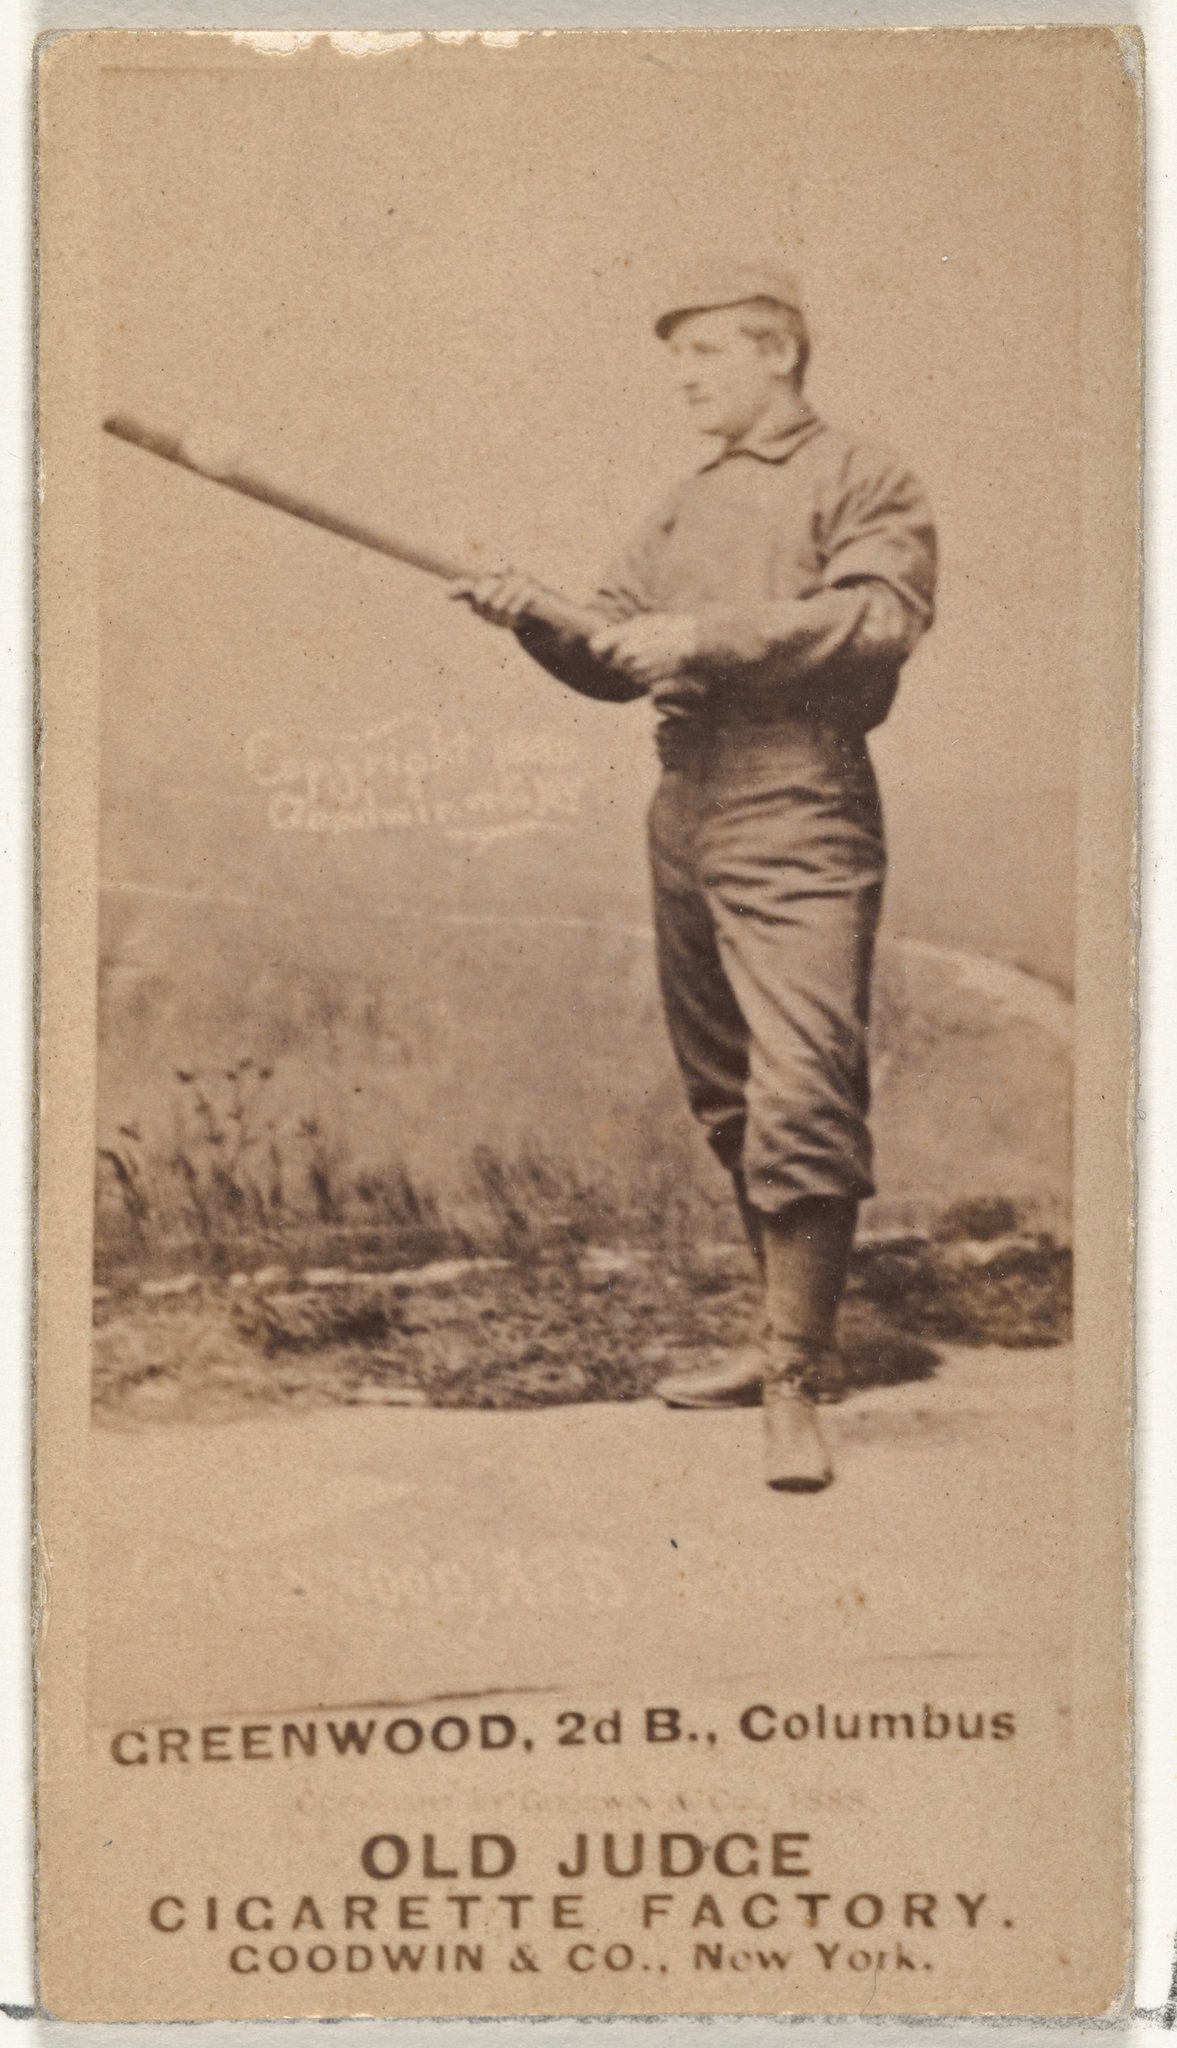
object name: baseball card, photograph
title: William F. "Bill" Greenwood, 2nd Base, Cleveland, from the Old Judge series (N172) for Old Judge Cigarettes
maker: goodwin & company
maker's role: publisher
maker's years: 1850-1950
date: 1888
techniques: albumen silver print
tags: men,portraits,baseball,athletes